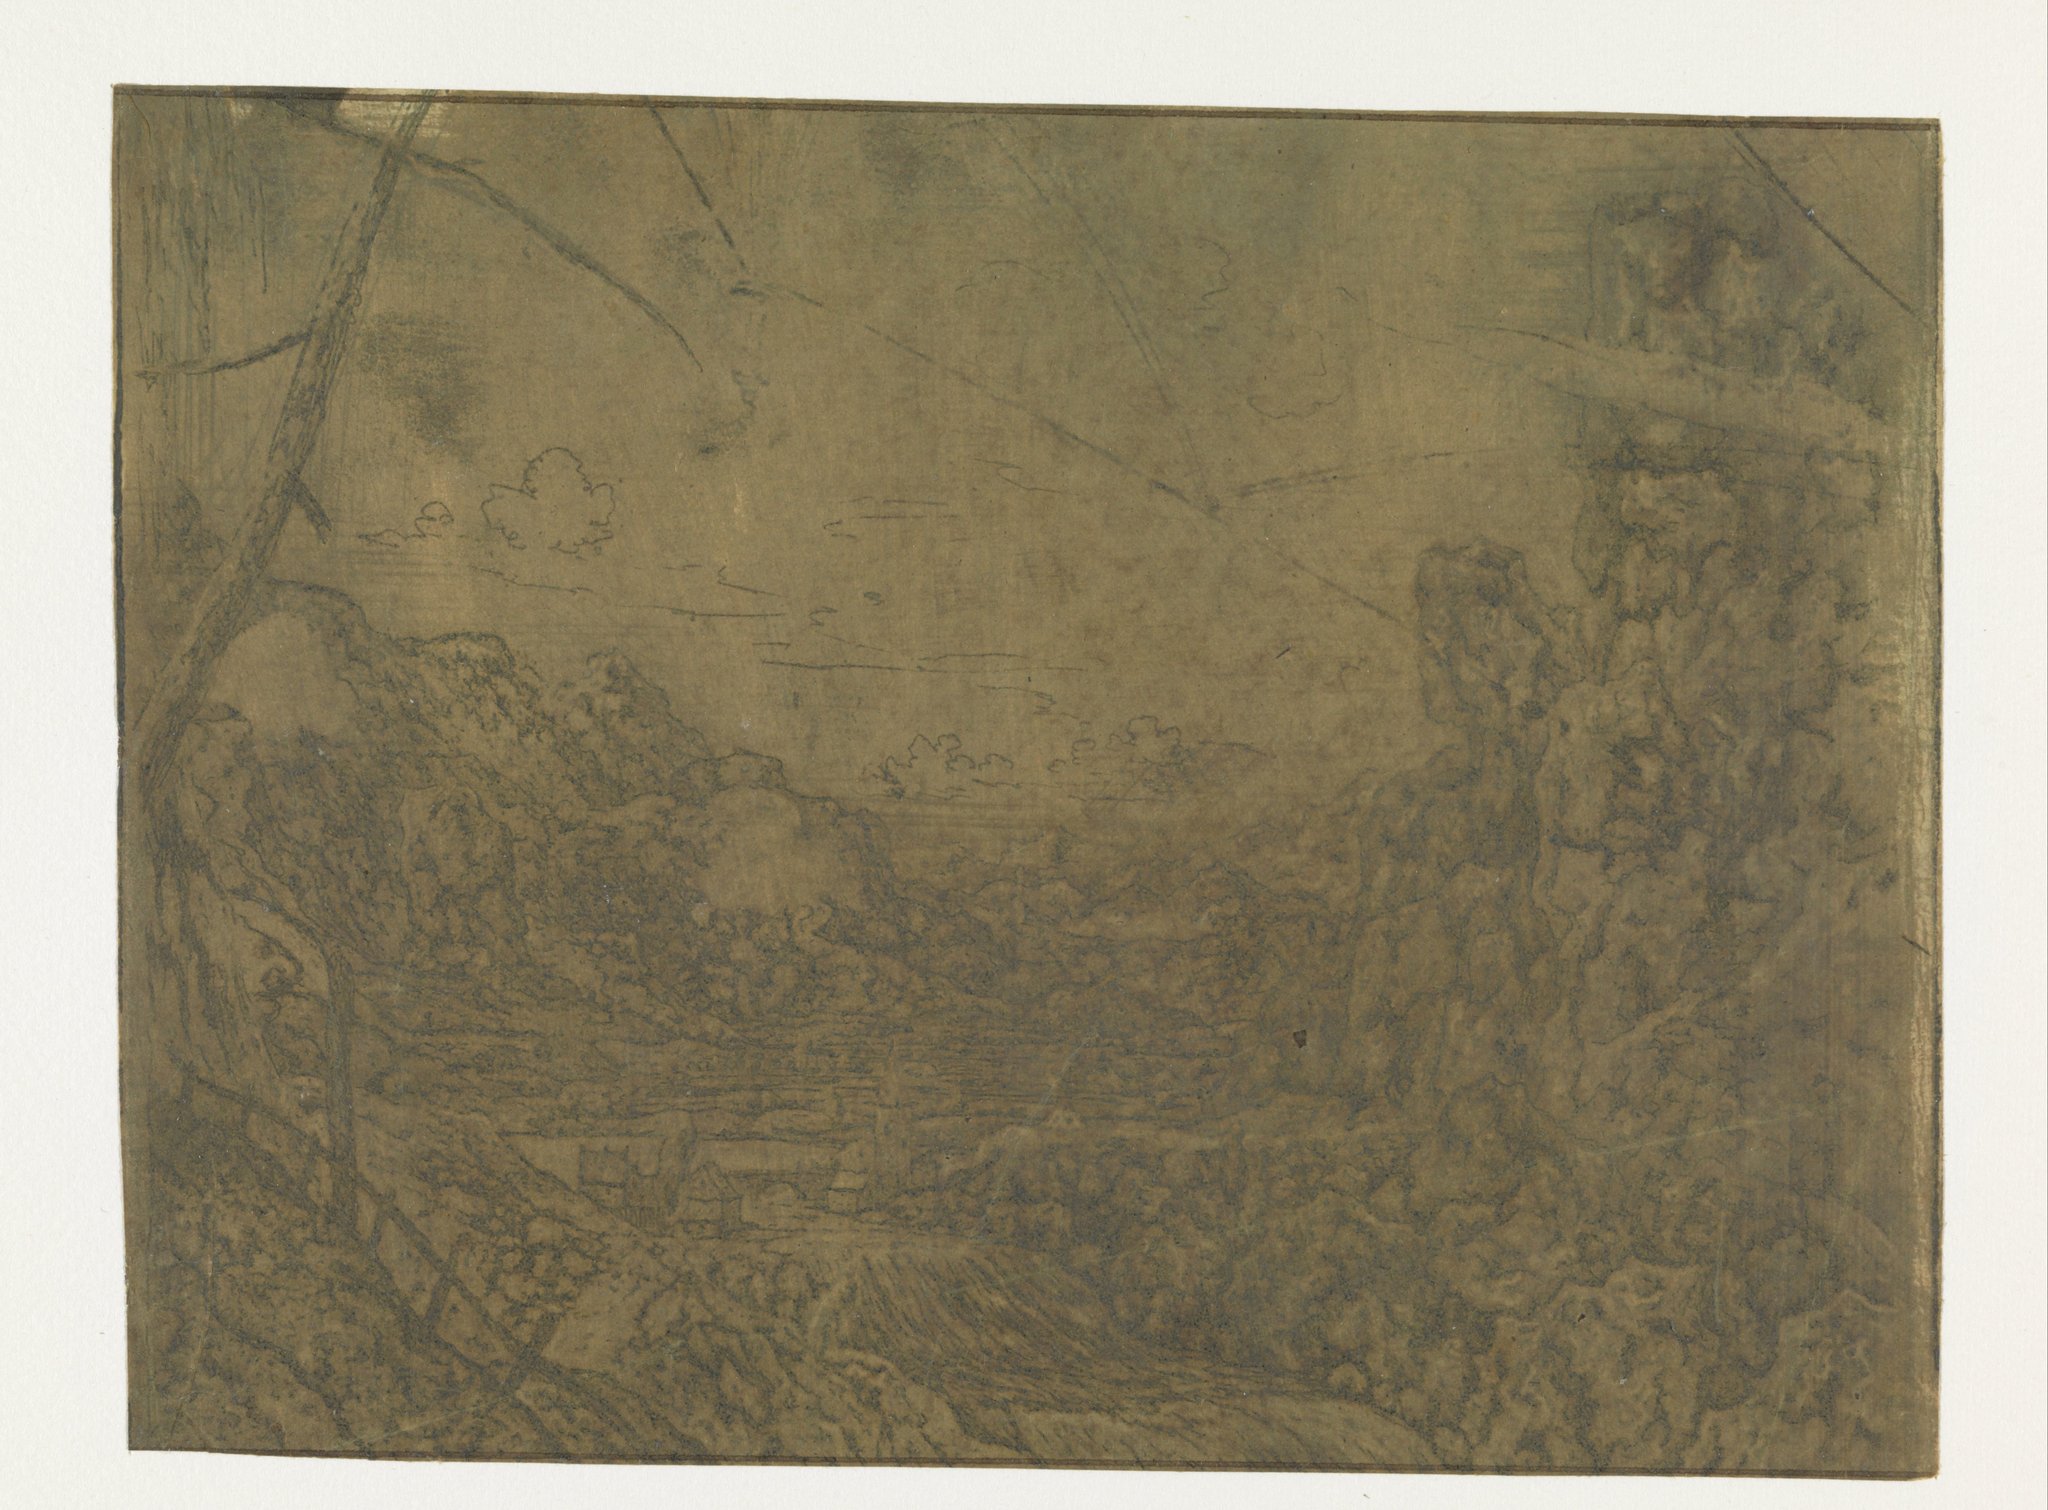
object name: print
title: Landscape with a Waterfall: First Version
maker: hercules segers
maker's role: draughtsman, painter, print maker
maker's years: 1589-1640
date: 1625-1627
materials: paper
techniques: drypoint, etching, hand coloring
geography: amsterdam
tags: waterfall, mountains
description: Eerste versie van het landschap met een waterval. Geëtst op een fragment van een oorspronkelijk veel grotere etsplaat, waarop een schip was voorgesteld.